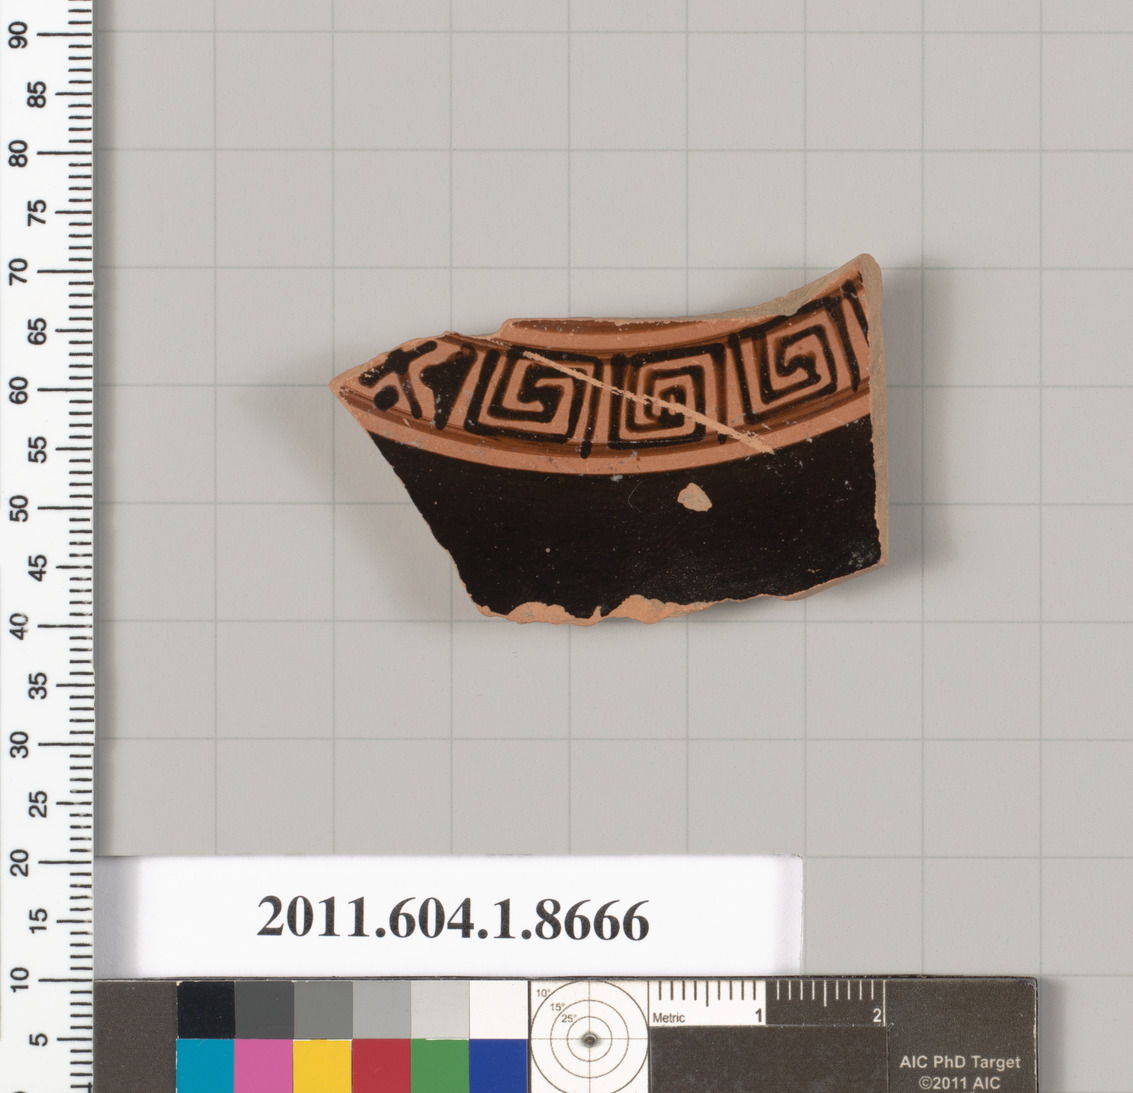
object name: kylix fragment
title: Terracotta fragment of a stemless kylix (drinking cup)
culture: greek, attic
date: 475-451 BCE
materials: terracotta